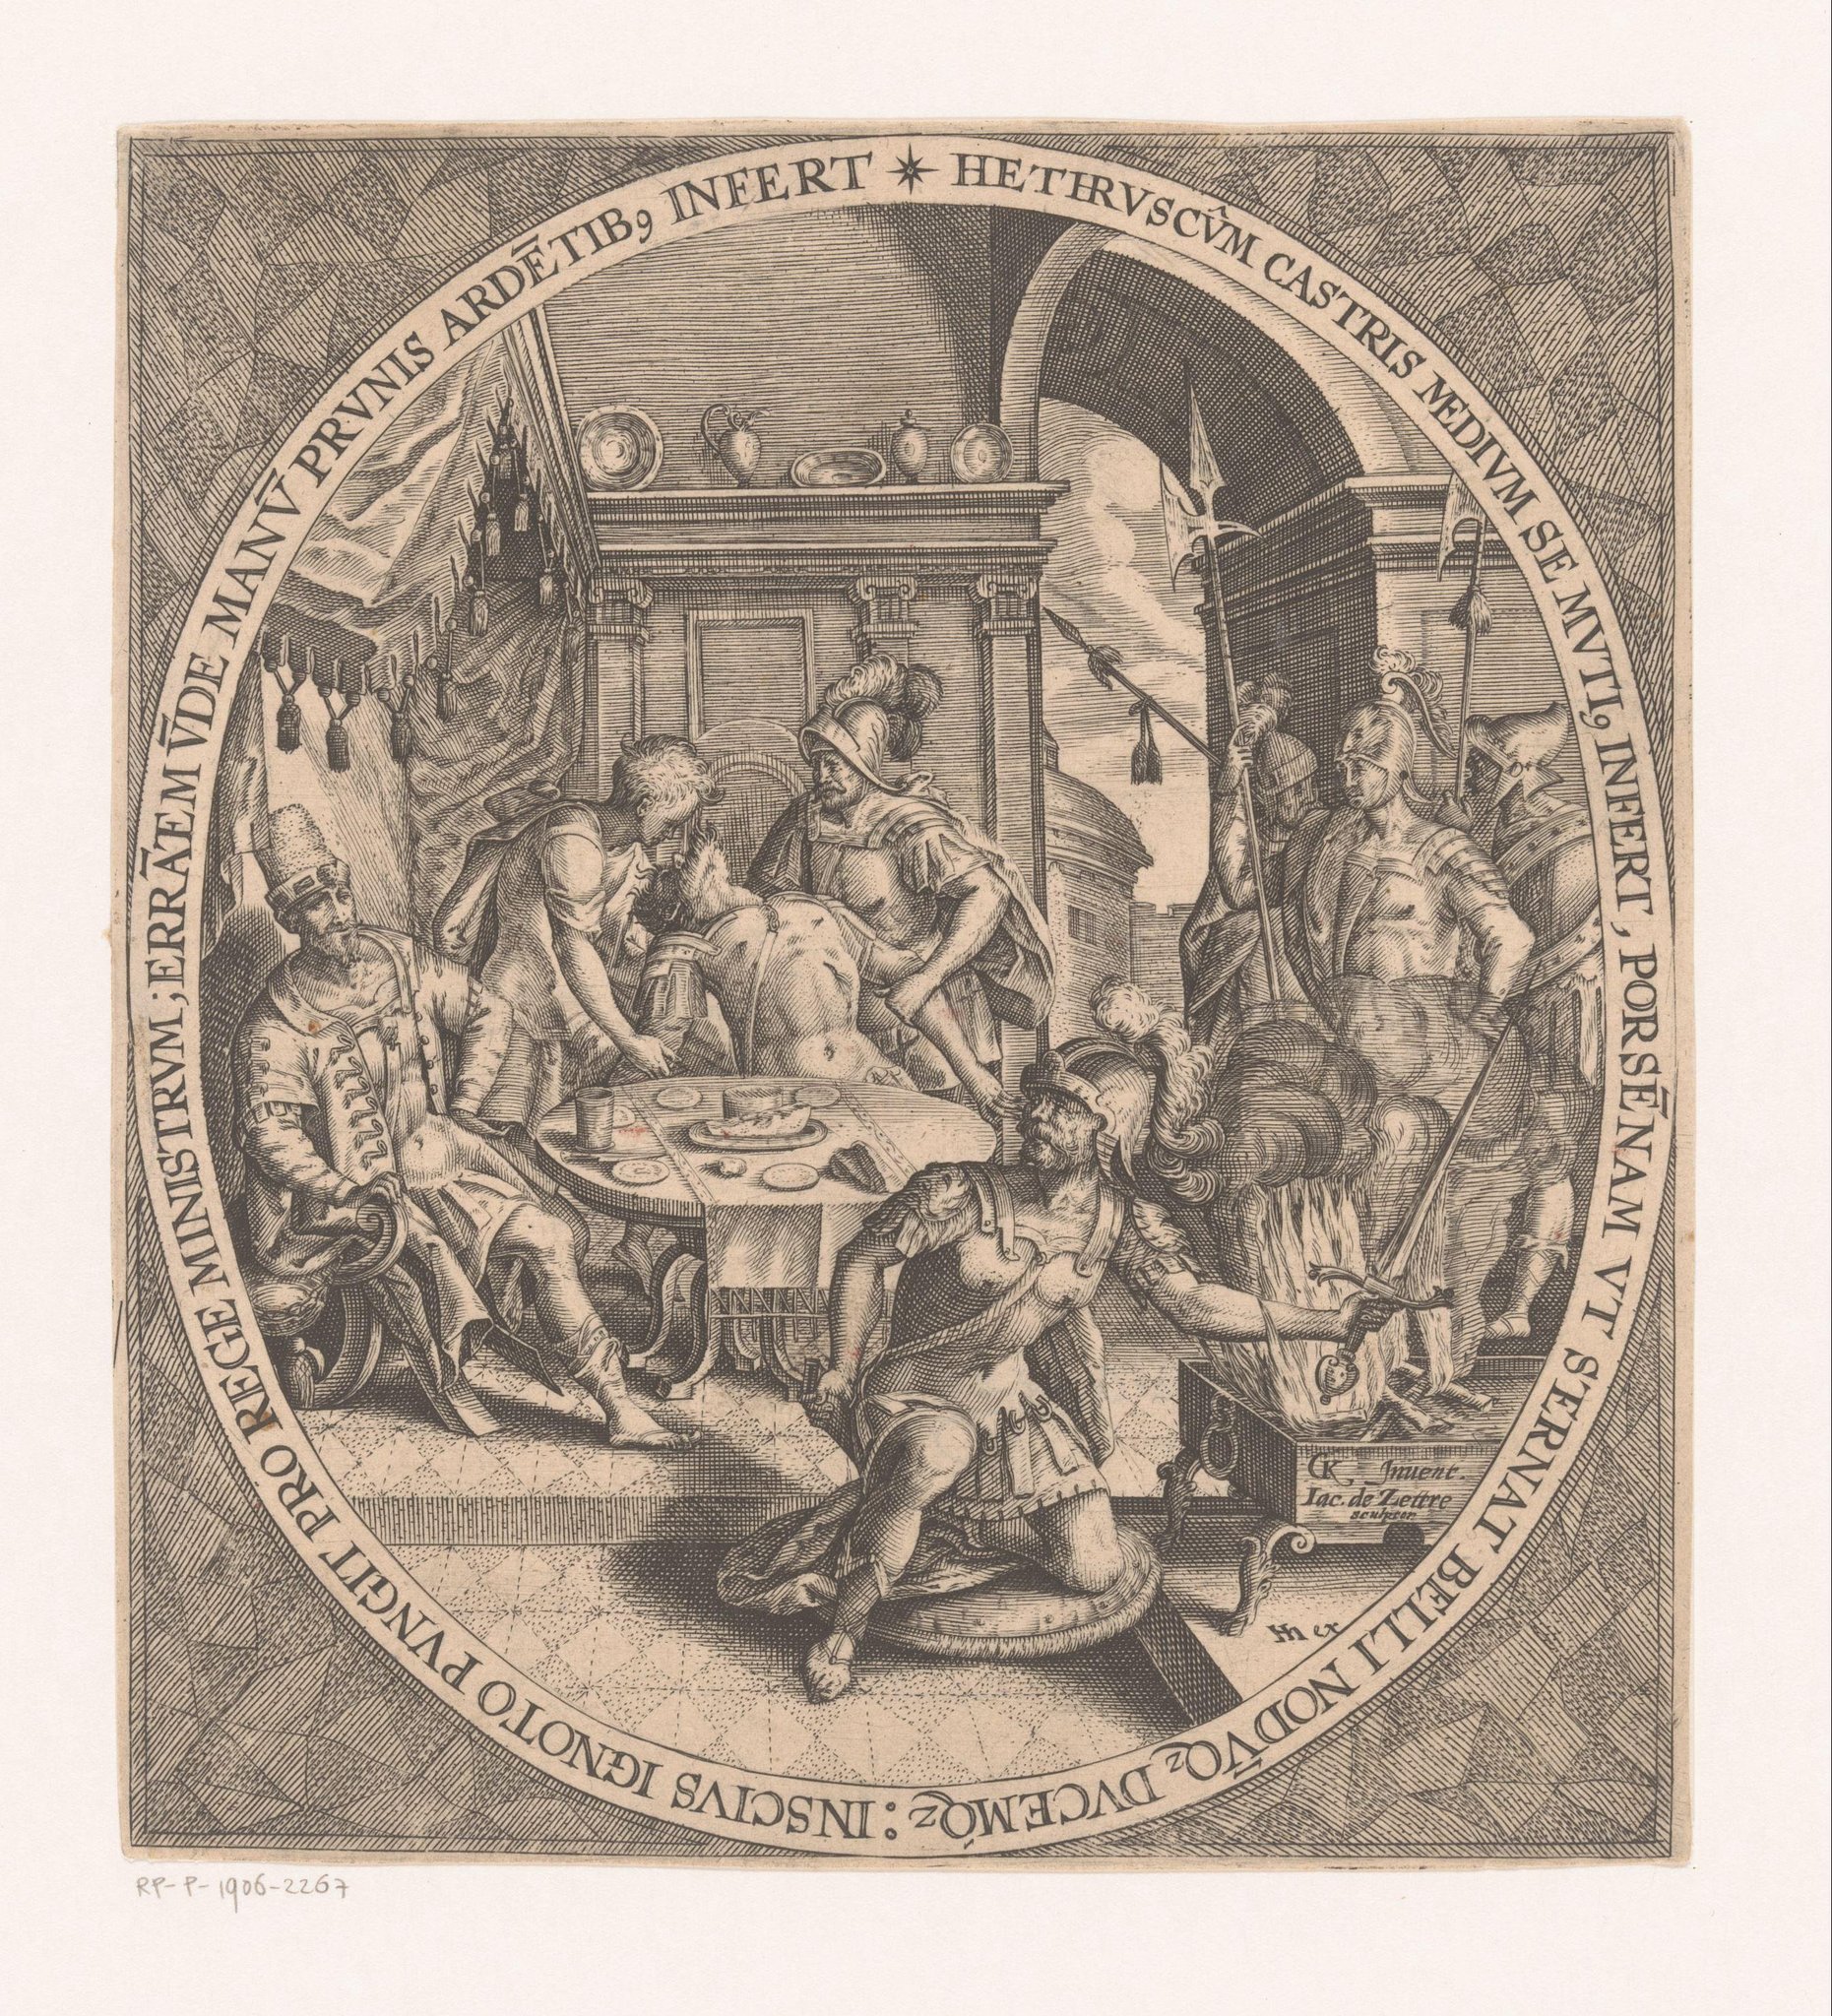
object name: print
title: Caius Mucius Scaevola steekt zijn hand in het vuur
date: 1583-1650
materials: paper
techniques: engraving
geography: germany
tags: gaius mucius scaevola before porsena: he thrusts his right hand into the flames (the body of the king's secretary who erroneously had been killed instead of porsena may be seen lying on the ground)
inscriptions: collector's mark: Lugt 2228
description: Na per ongeluk de secretaris van de Etruskische koning Lars Porsenna te hebben gedood, steekt Caius Mucius Scaevola zijn hand in een altaarvuur om te tonen hoe weinig hij aan zijn eigen leven hecht.